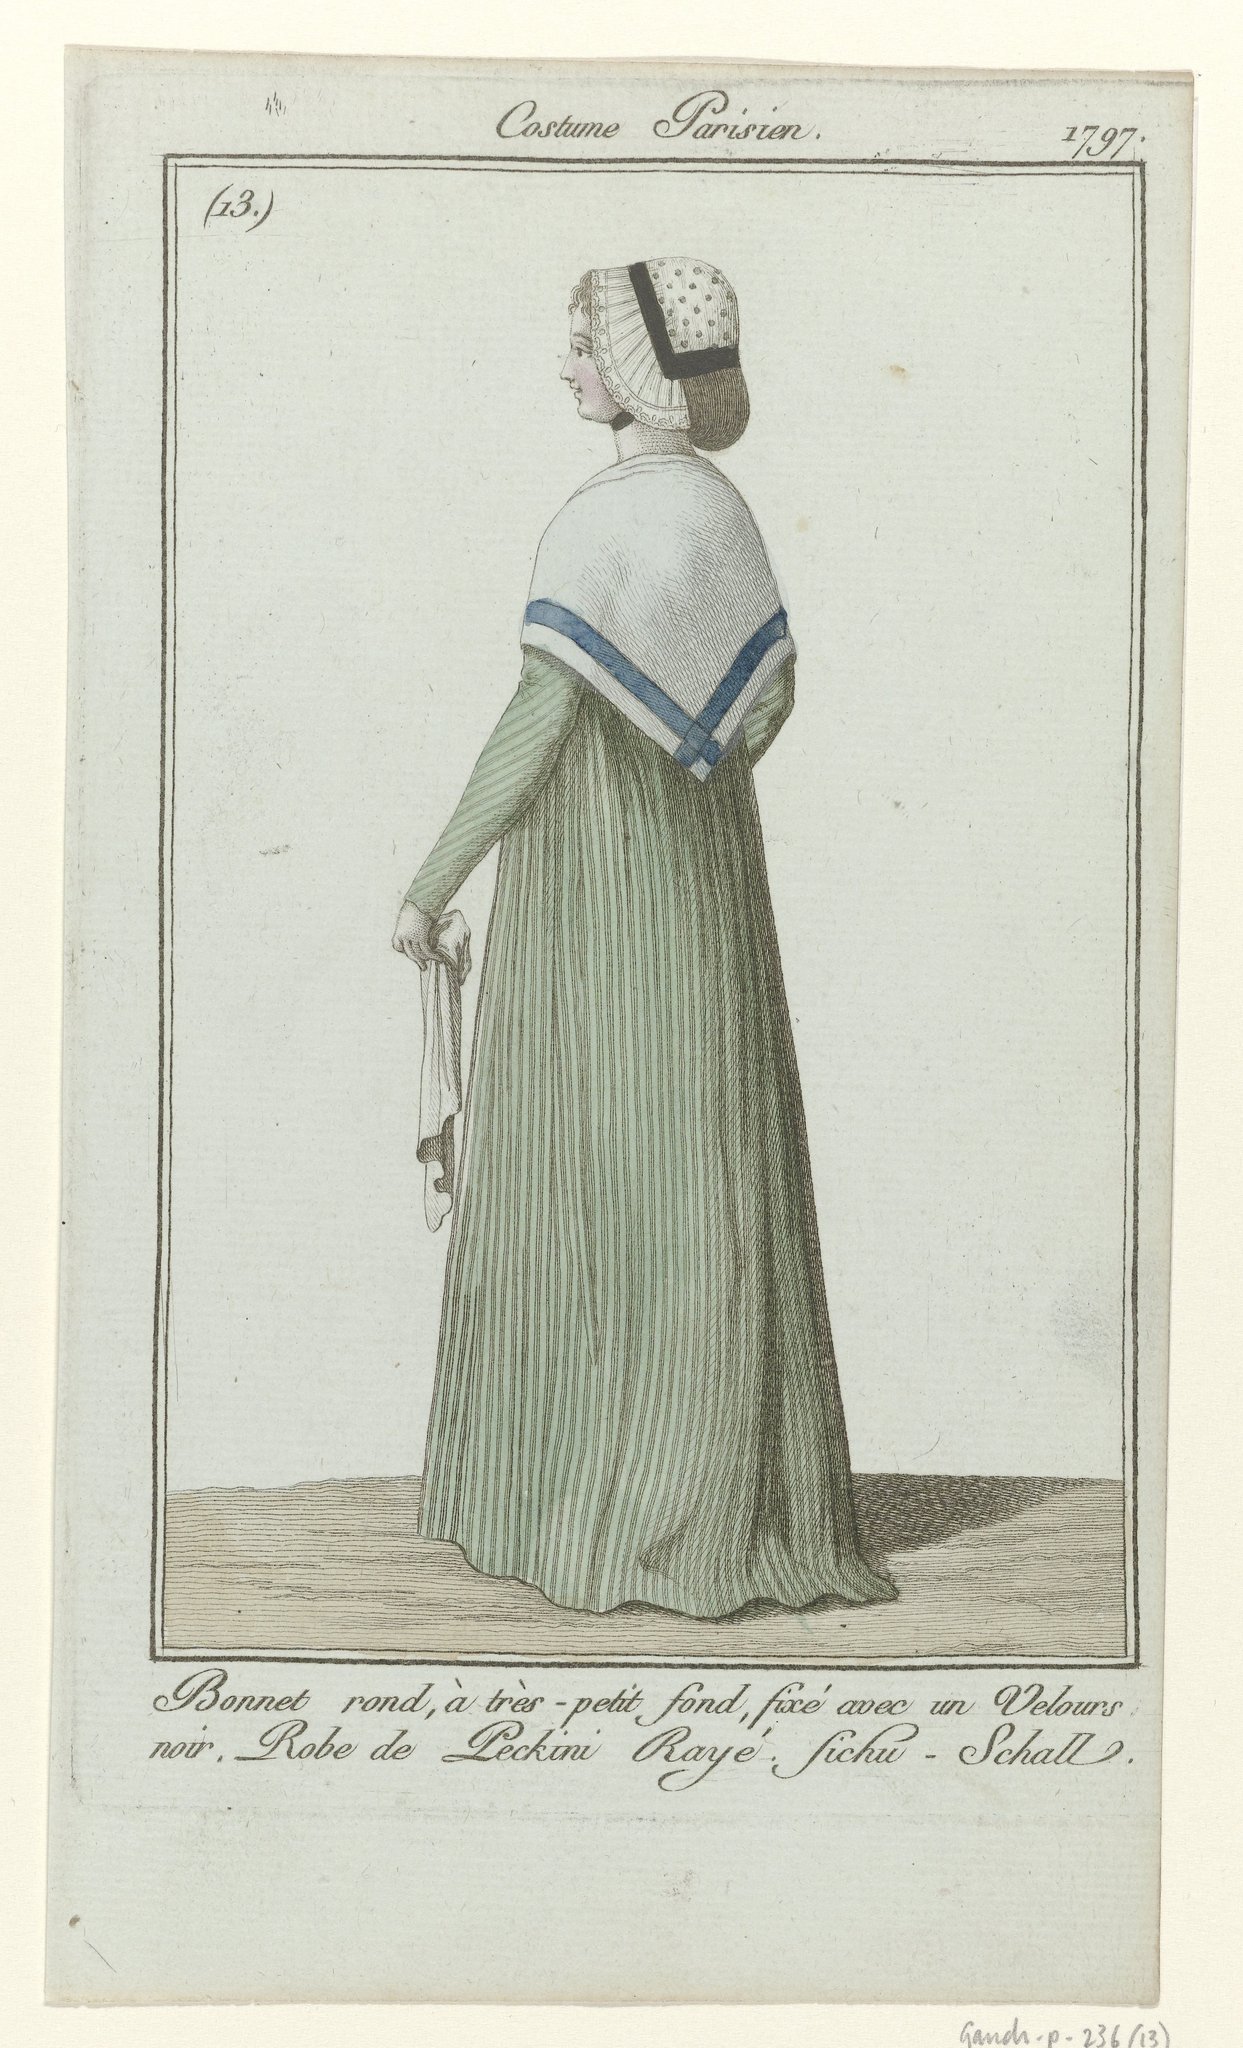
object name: fashion print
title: Journal des Dames et des Modes, Costume Parisien, 3 décembre 1797, (13) : Bonnet rond, à tres-petit fond (...)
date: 1797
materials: paper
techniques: engraving, hand coloring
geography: paris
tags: handkerchief (+ women's clothes), clothing for the upper part of the body (shawl) (+ women's clothes), head-gear: cap (+ women's clothes), fashion plates, dress, gown (+ women's clothes)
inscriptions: caption: ‘Bonnet rond, à très-petit fond, fixé avec un Velours noir. Robe de Peckini Rayé. Fichu-Schall.’, title: ‘Costume Parisien.’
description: Ronde muts met zeer kleine bol, vastgemaakt met een zwart fluwelen band. Japon van gestreepte 'Peckini'. 'Fichu - Schall' om de schouders. Zakdoek. De prent maakt deel uit van het modetijdschrift Journal des Dames et des Modes, uitgegeven door Sellèque, Parijs, 1797-1839.